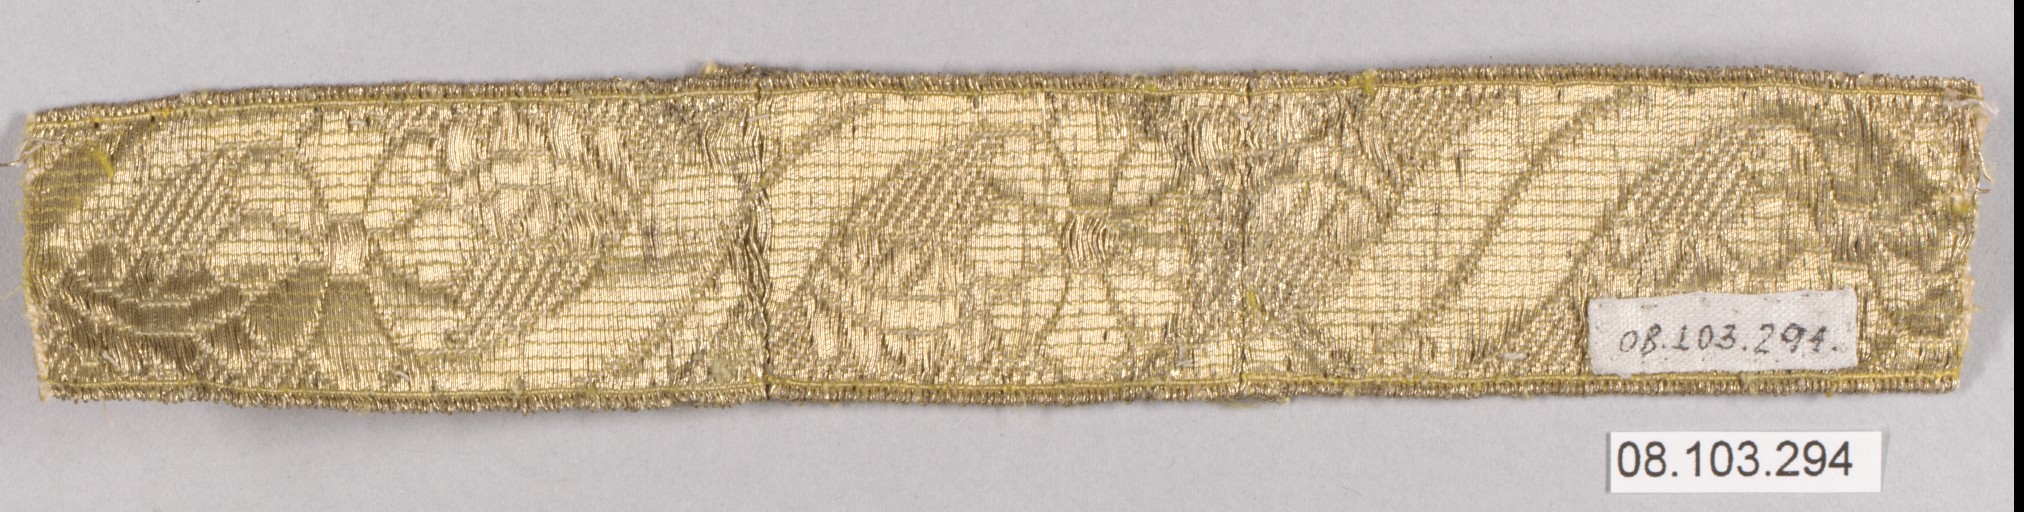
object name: galloon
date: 1601-1800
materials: metal thread, silk